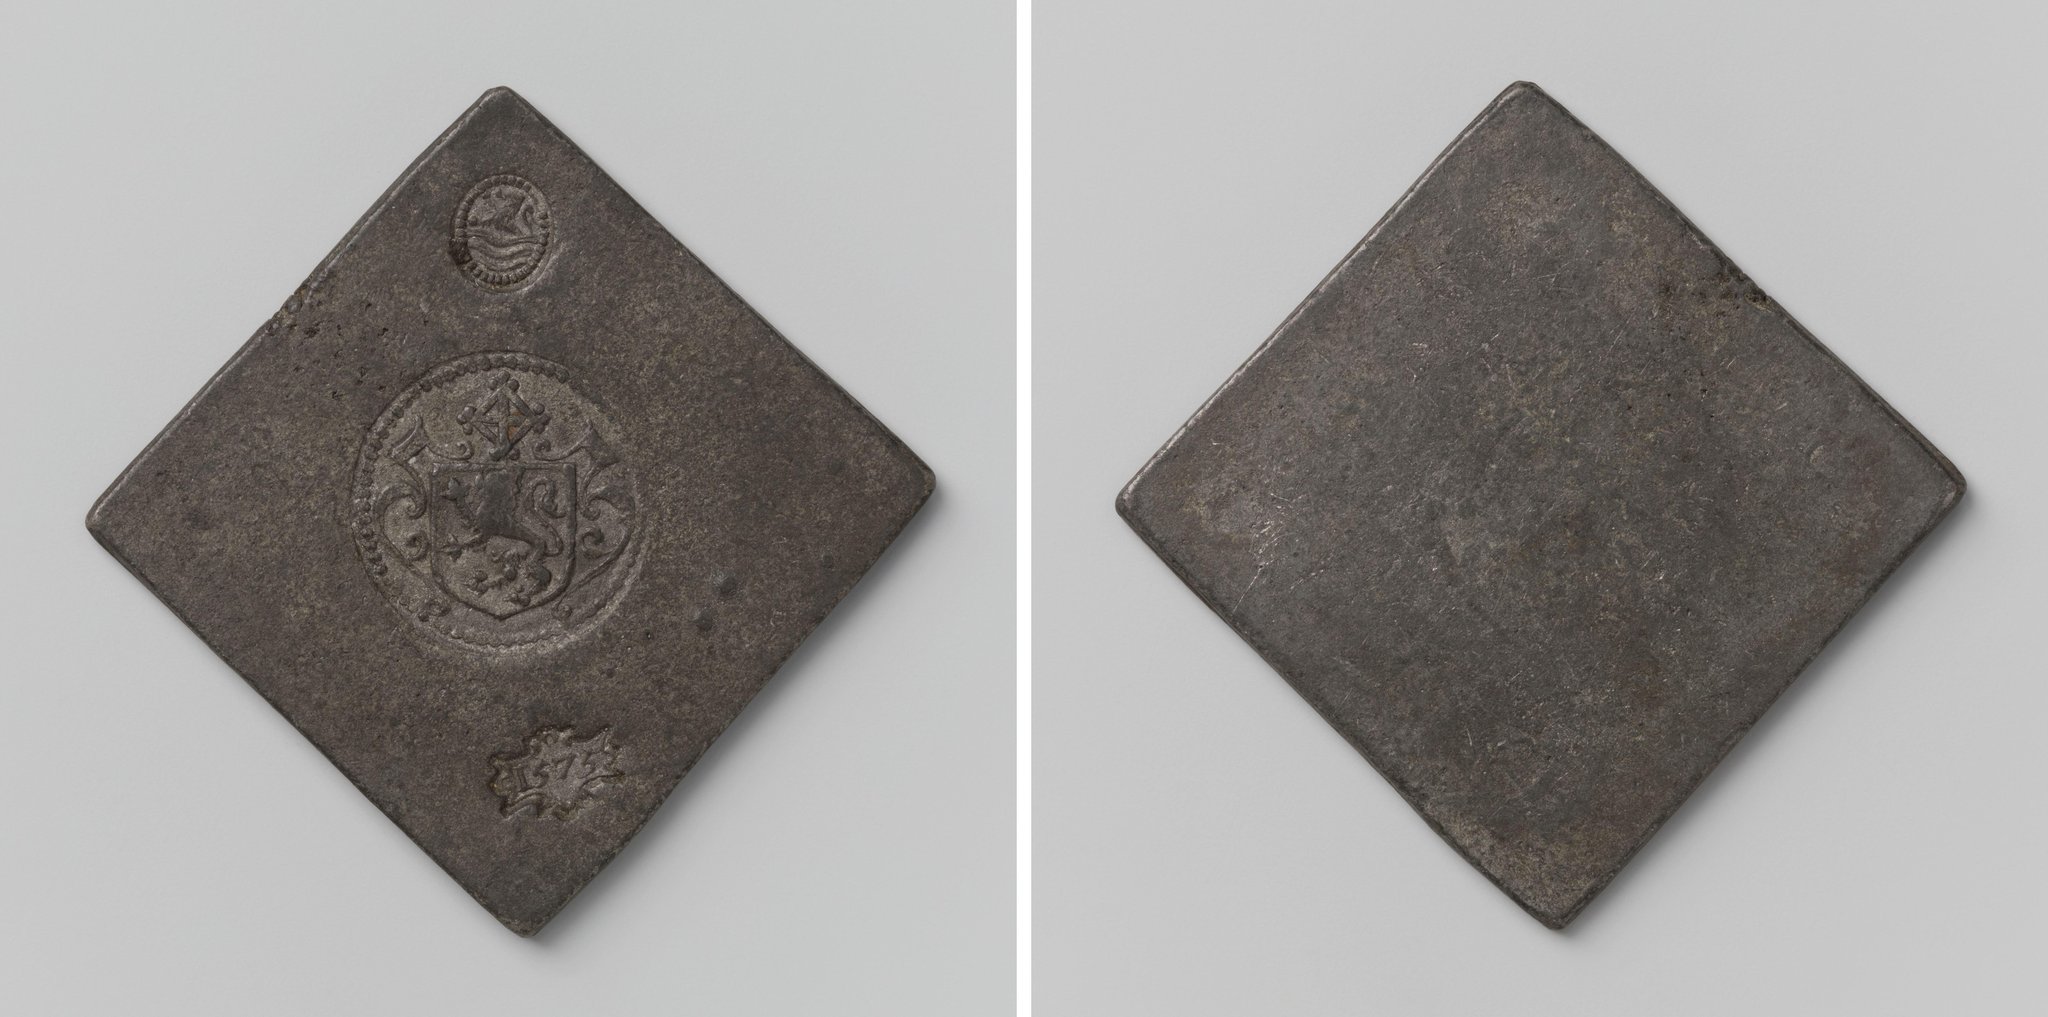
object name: siege coin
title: Daalder, noodmunt uit Zierikzee, geslagen tijdens het beleg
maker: Anonymous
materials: tin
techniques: striking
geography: netherlands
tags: zierikzee, tachtigjarige oorlog, beleg van zierikzee